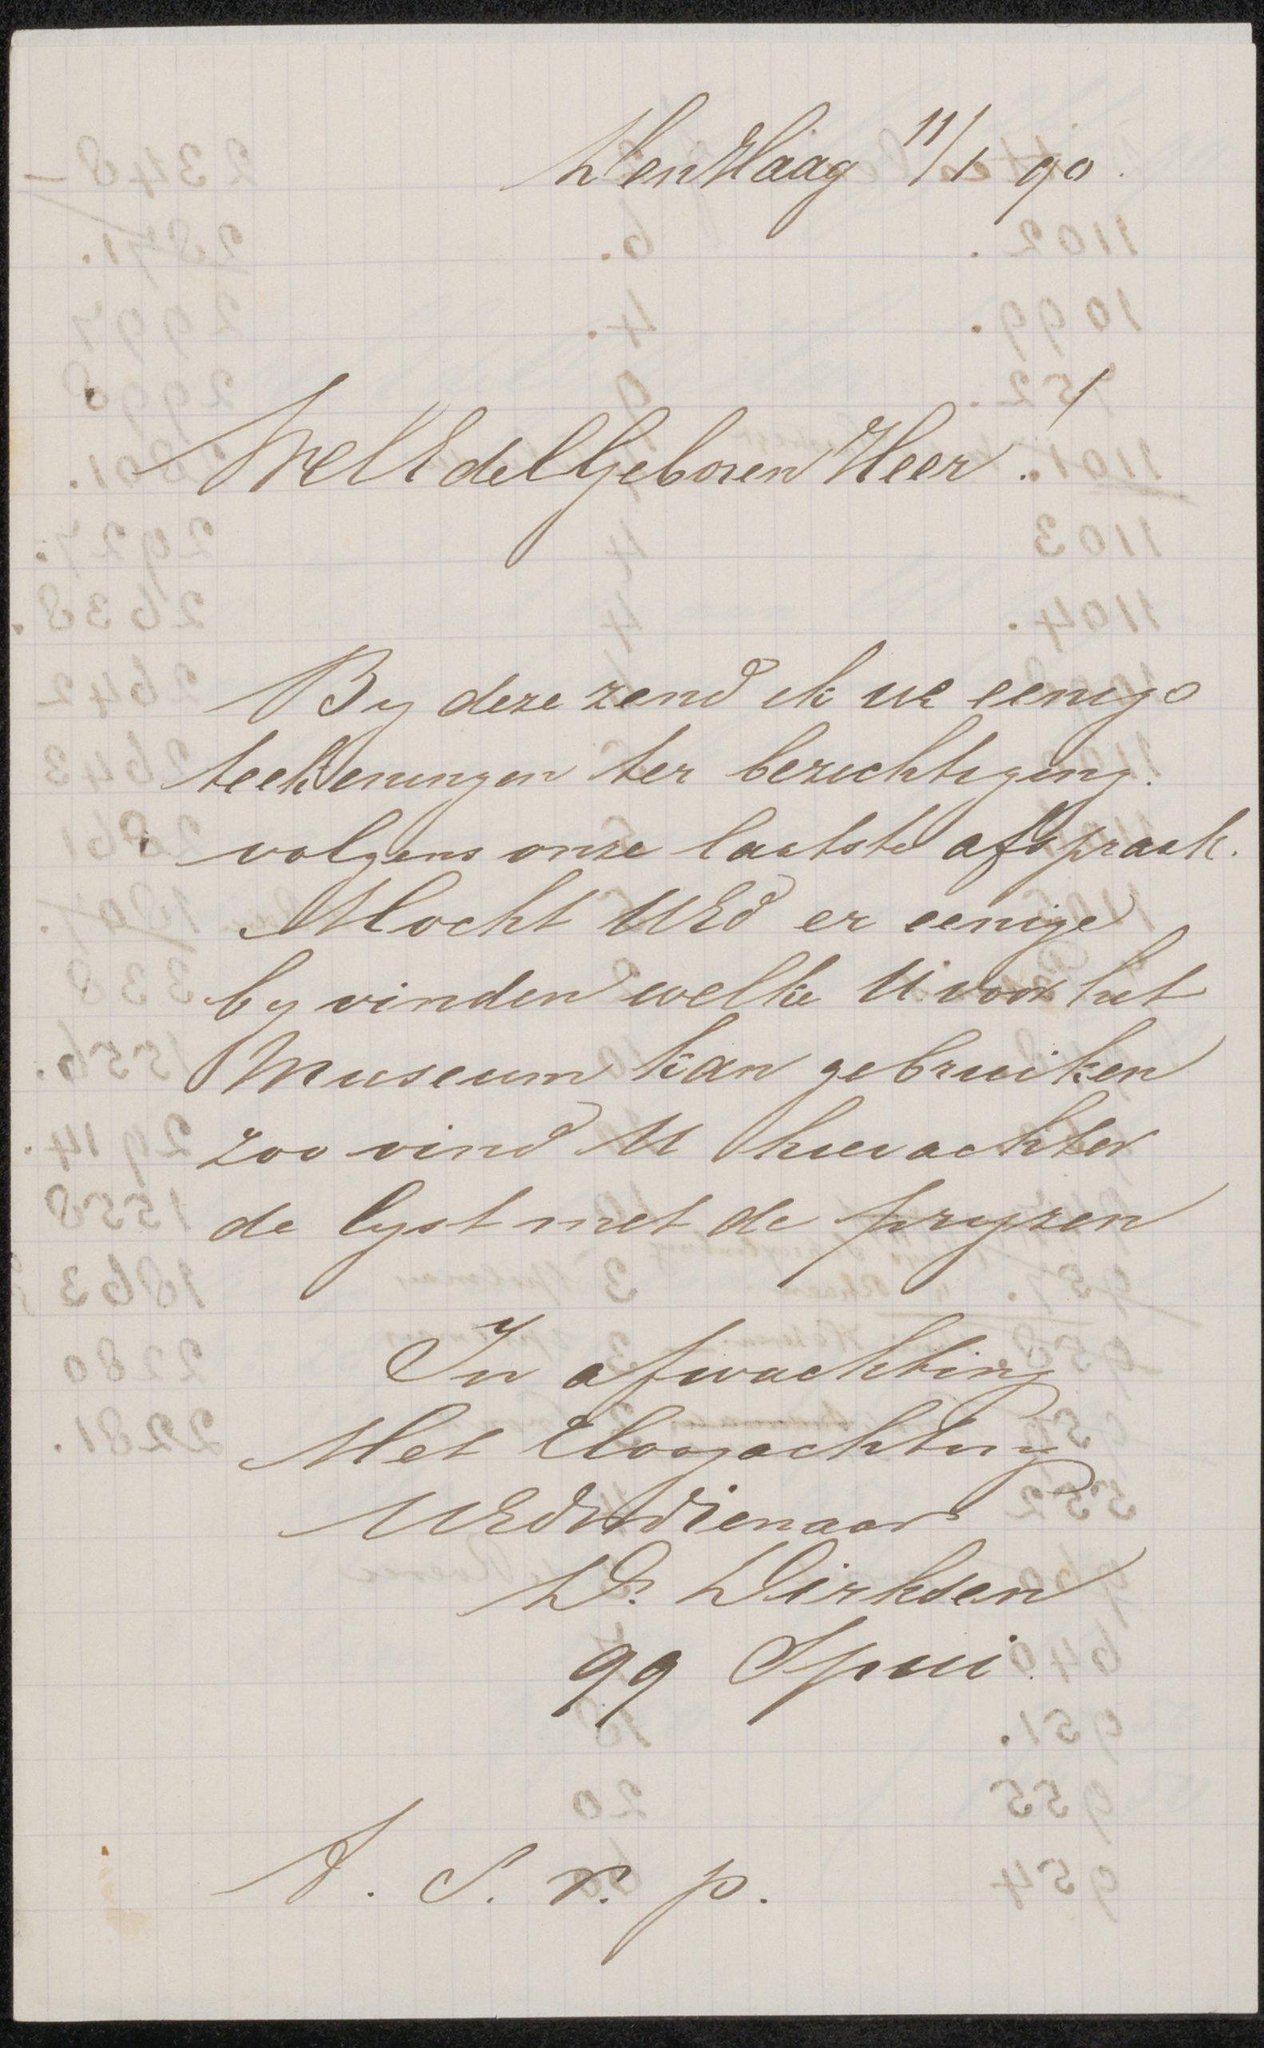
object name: letter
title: Brieven aan anoniem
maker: dirk dirksen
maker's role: painter, print maker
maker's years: 1811-1885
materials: ink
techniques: pen, writing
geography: the hague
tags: drawing, the graphic arts, art collecting, money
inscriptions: collector's mark: ‘RPK’